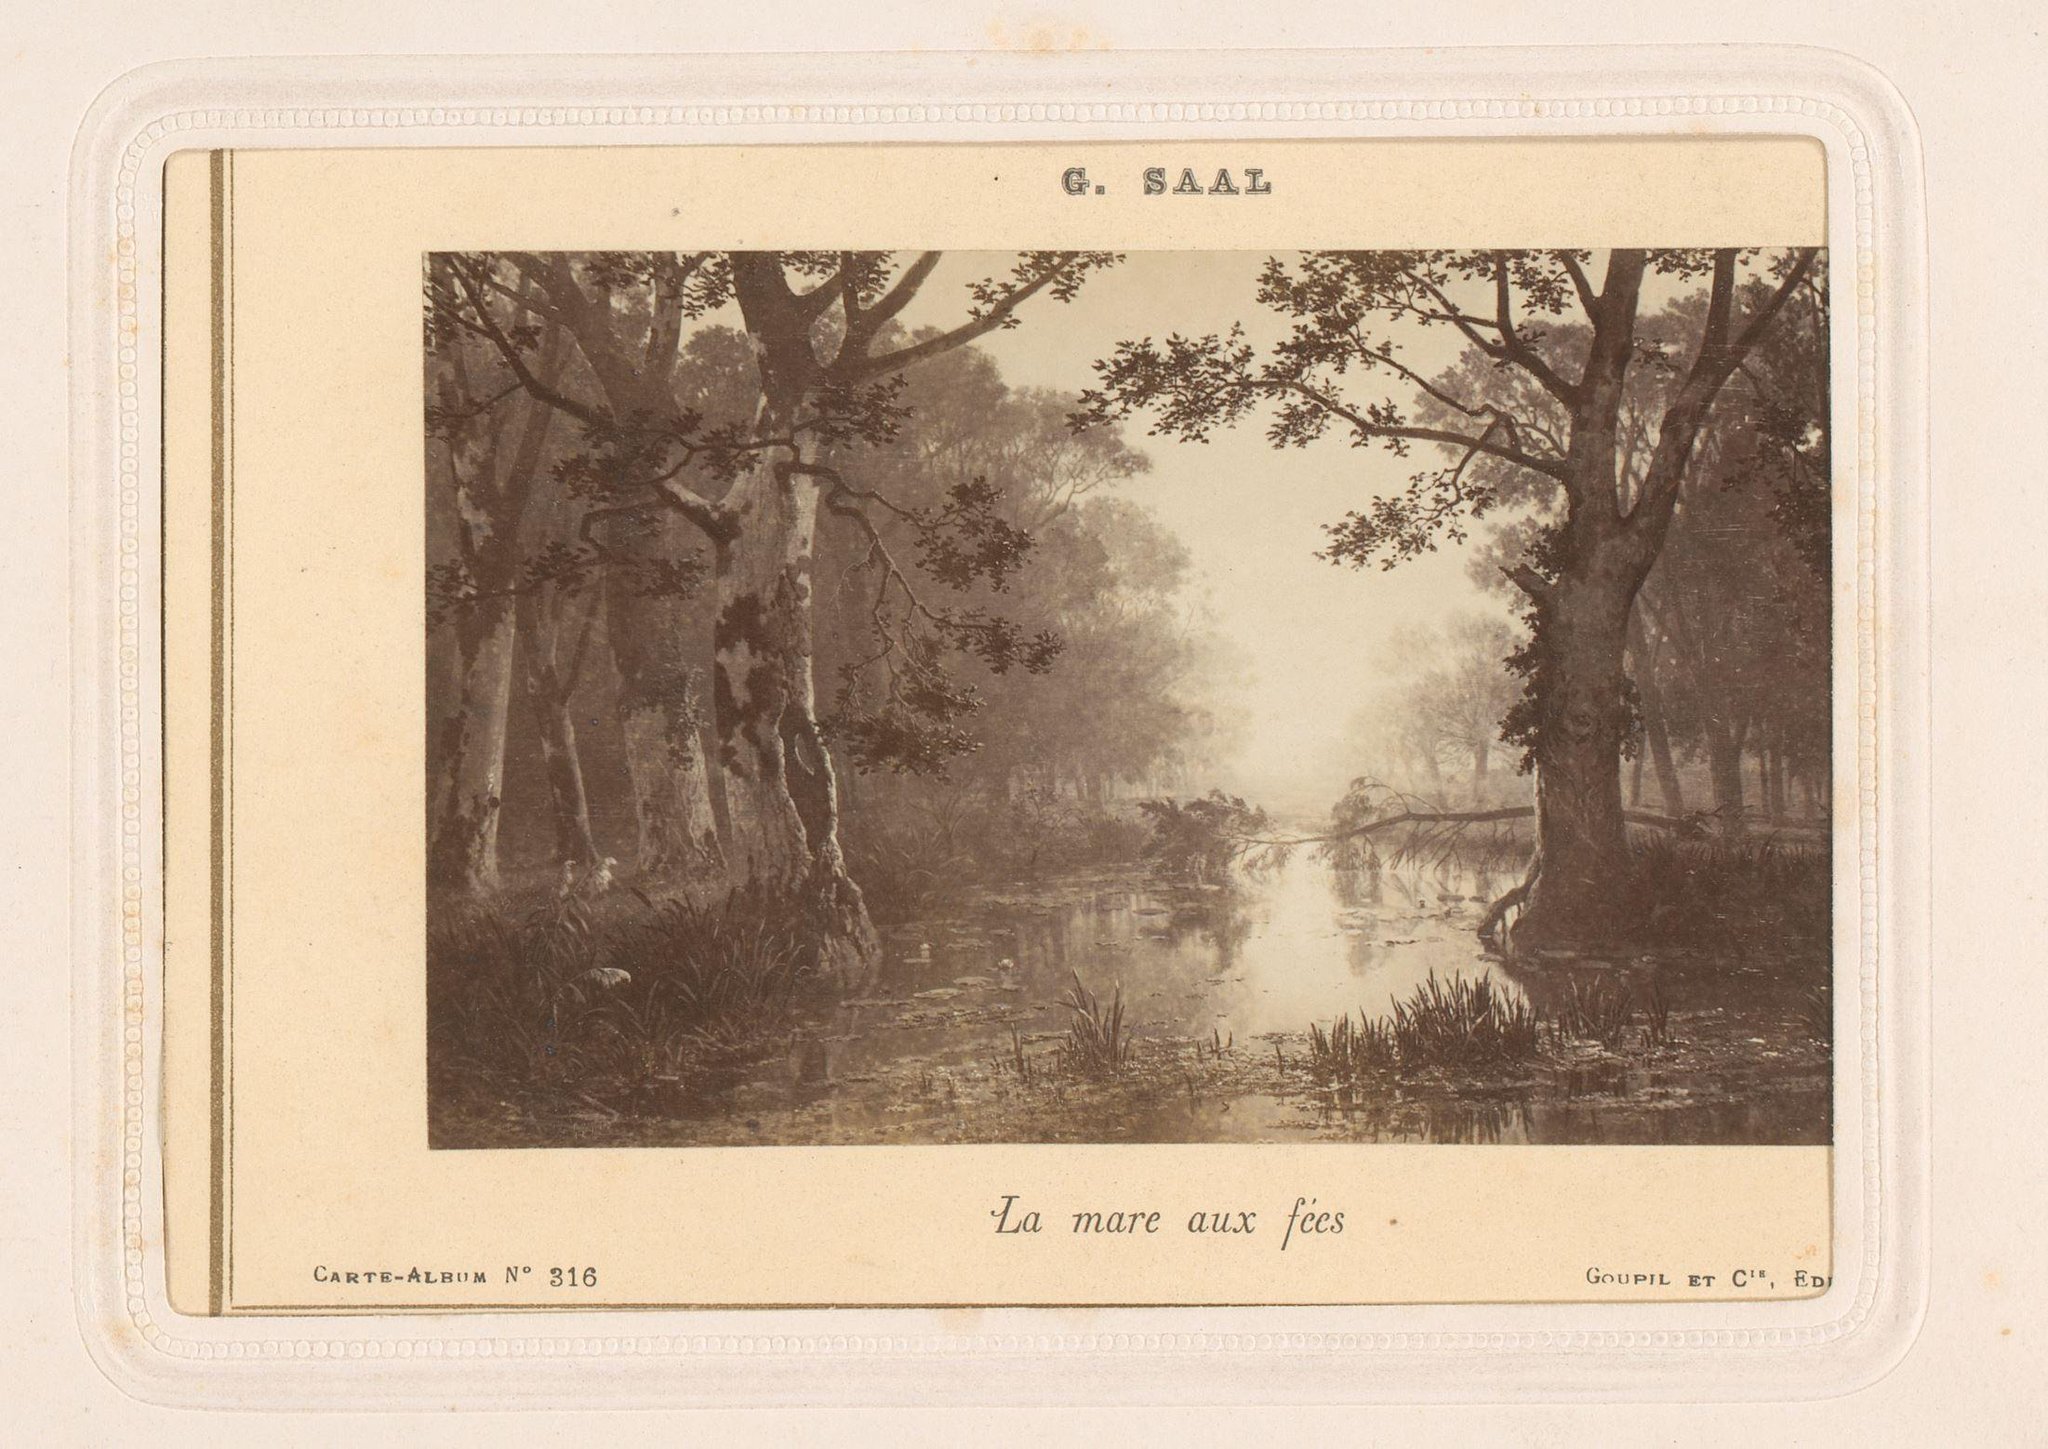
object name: photograph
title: La mare aux fées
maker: georg eduard otto saal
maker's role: painter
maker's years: 1817-1870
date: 1860-1890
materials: cardboard, photographic support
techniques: albumen print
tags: trees, landscapes, brook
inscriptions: inscription: ‘Carte-Album No 316’